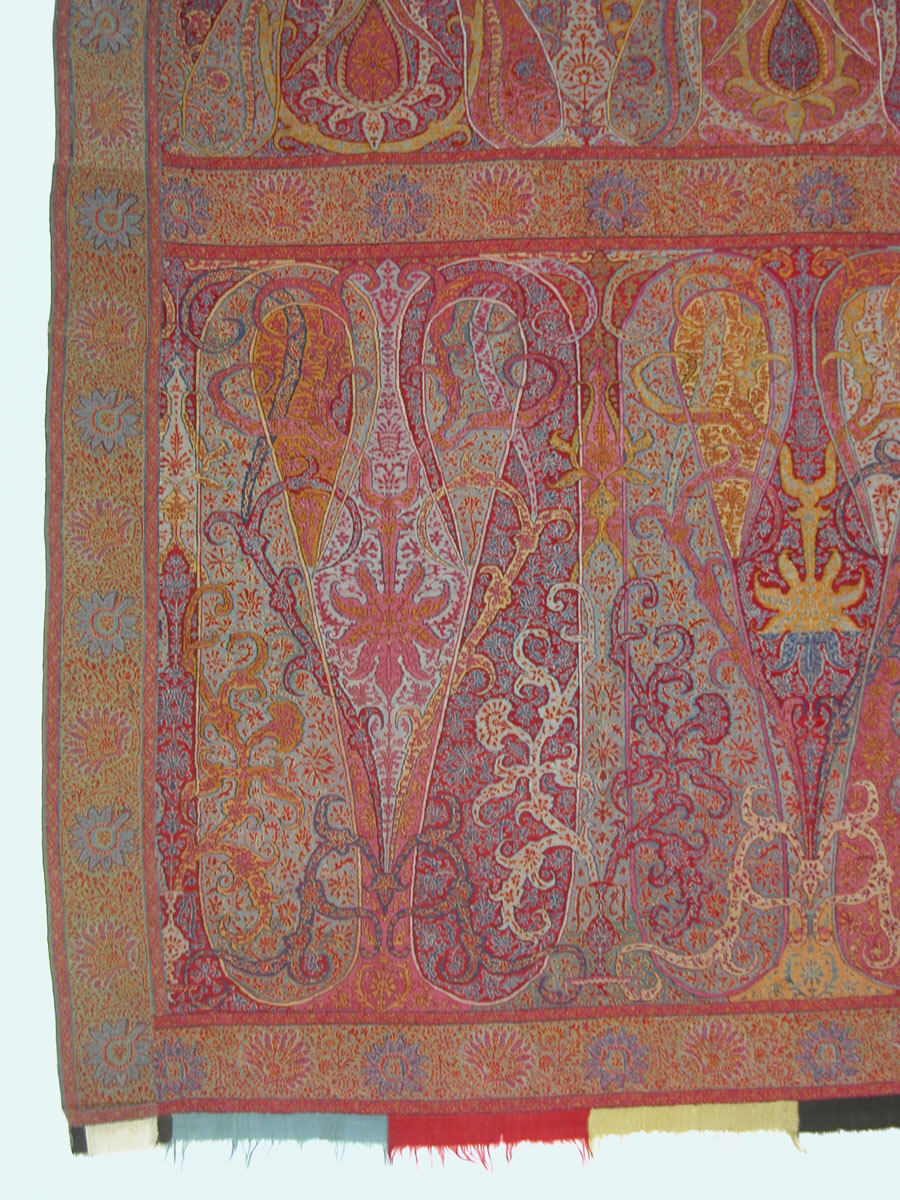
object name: shawl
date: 1840-1850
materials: wool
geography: india